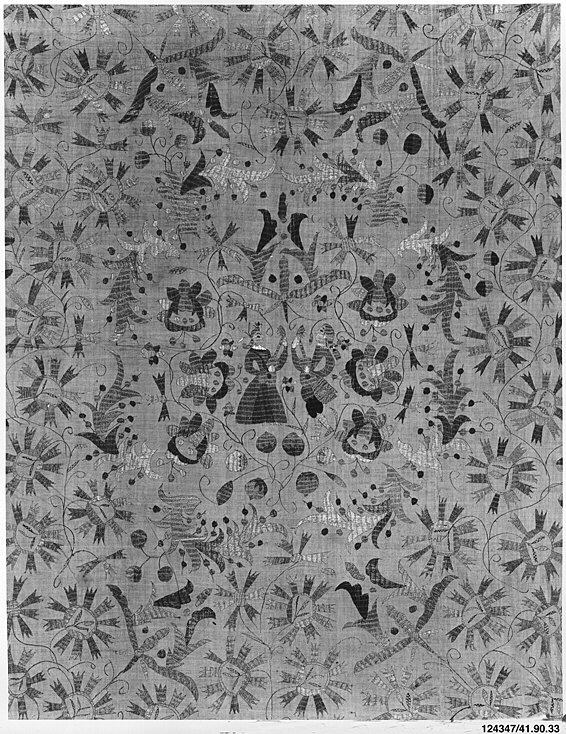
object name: hanging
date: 1701-1800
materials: linen, silk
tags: men,women